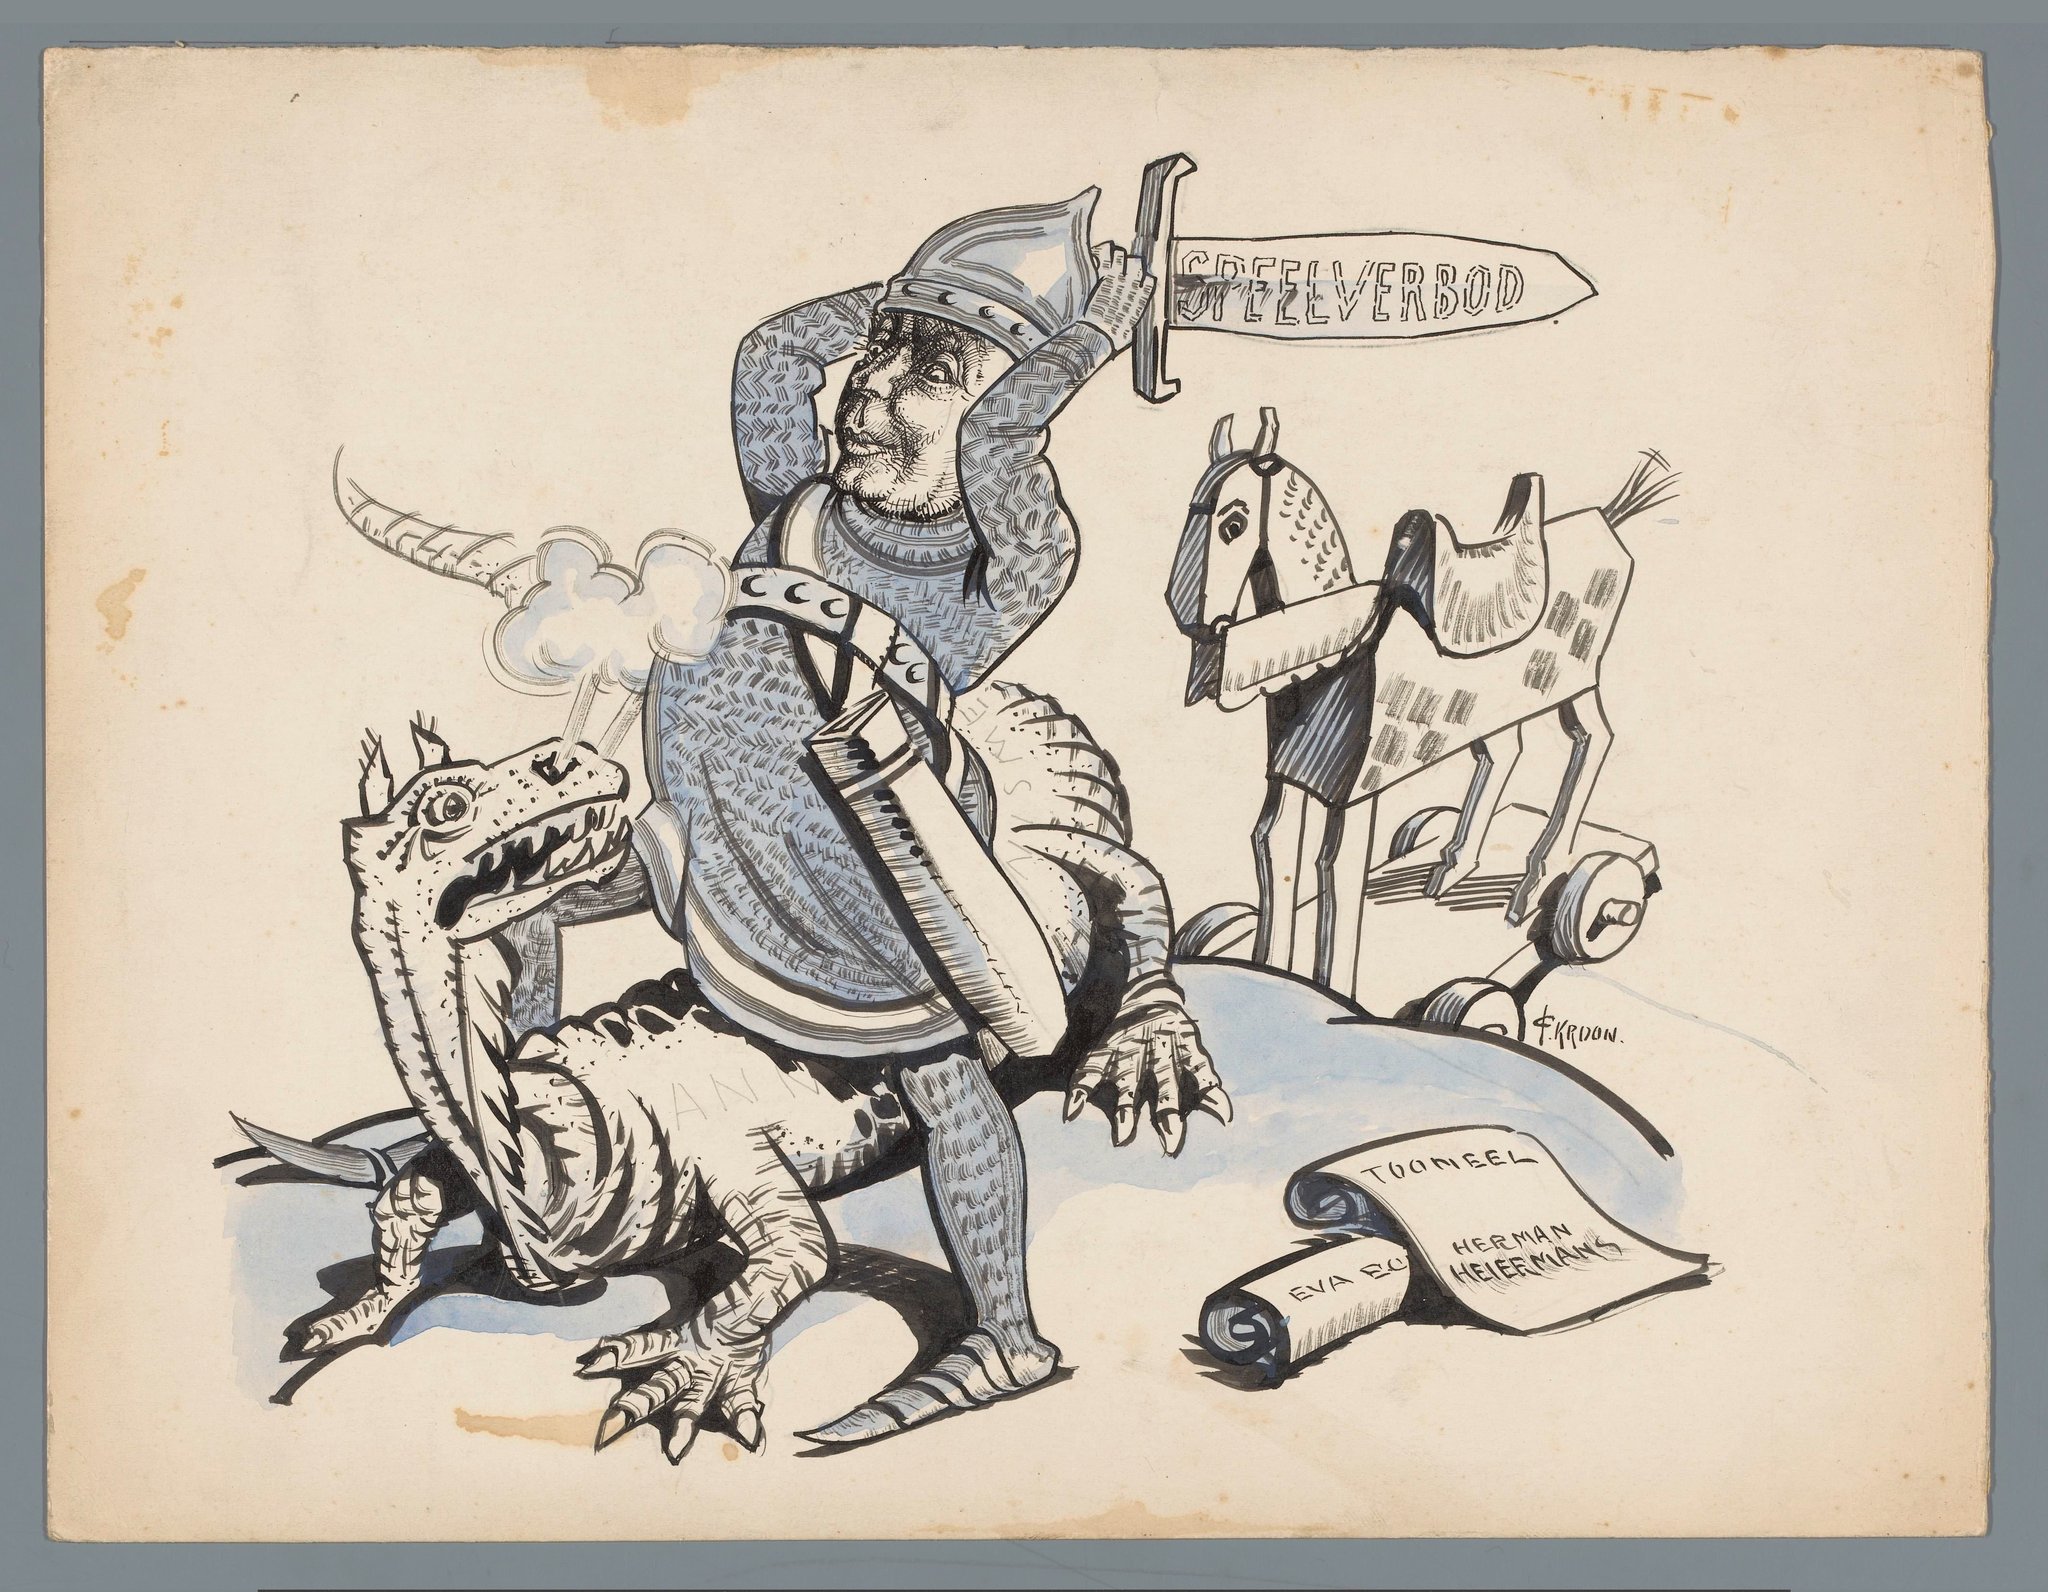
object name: drawing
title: Sint Joris en de draak en speelverbod voor Herman Heijermans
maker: patricq kroon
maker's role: draughtsman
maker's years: 1862-1941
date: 1919-1924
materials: ink, paint, paper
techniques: brush, pen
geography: netherlands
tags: herman heijermans, hobby-horse, the warrior martyr george (georgius); possible attributes: banner (red cross on white field), (red) cross, dragon, (white) horse, broken lance, shield (with cross), sword, political caricatures and satires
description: Een politicus als Sint Joris is van zijn hobbelpaard afgestegen en bestrijdt een draak met zijn zwaard aangeduid als 'Speelverbod'. Op de voorgrond twee rollen papier aangeduid als 'Tooneel Herman Heiermans' en 'Eva Bo'[nheur = 1919]. Op de achterzijde van een blad een schets voor een andere cartoon. Ontwerp voor een politieke spotprent.